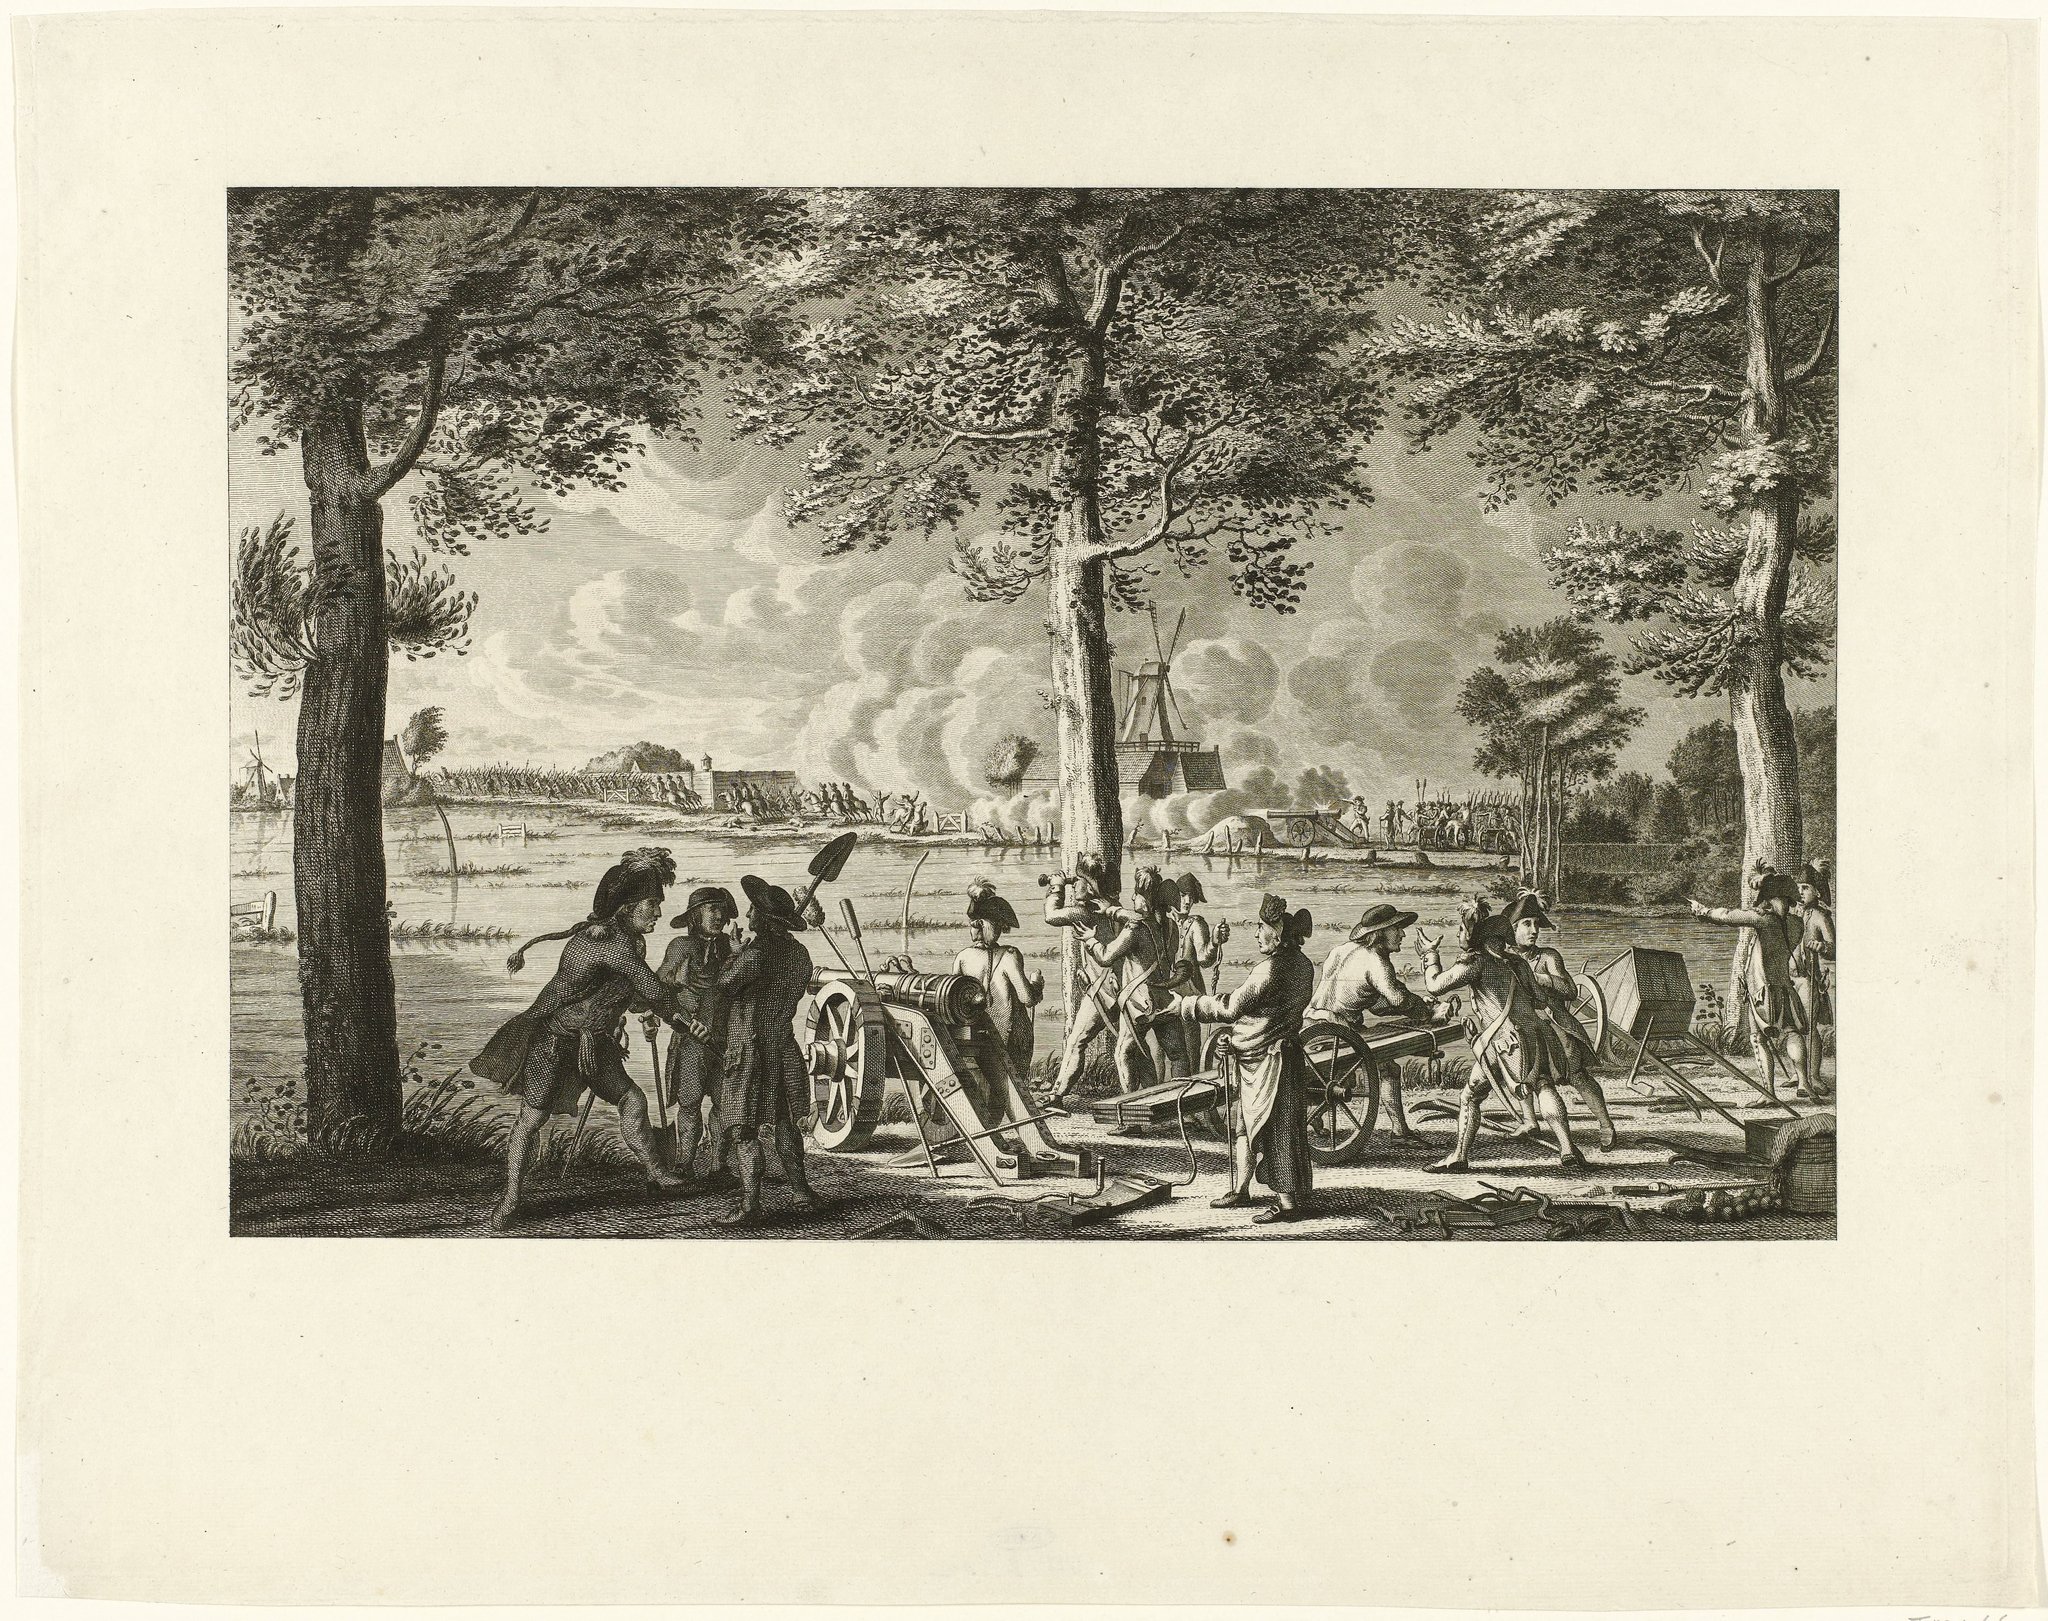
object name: print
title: Aanval op de stad Weesp, 30 september 1787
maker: cornelis brouwer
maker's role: print maker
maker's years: 1731-1803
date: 1791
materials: paper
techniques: engraving, etching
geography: northern netherlands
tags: (military) attack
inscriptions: collector's mark: Lugt 2228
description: Aanval op Weesp door de Pruisische troepen op 30 september 1787. De stad wordt verdedigd door de Amsterdamse en Weesper schutters onder commando van kolonel H. van de. Poll. Op de voorgrond de patriotten, in de verte de Pruisische troepen. Onderdeel van een groep van zeven prenten van de gevechten met de Pruissische troepen rond Amsterdam in 1787.